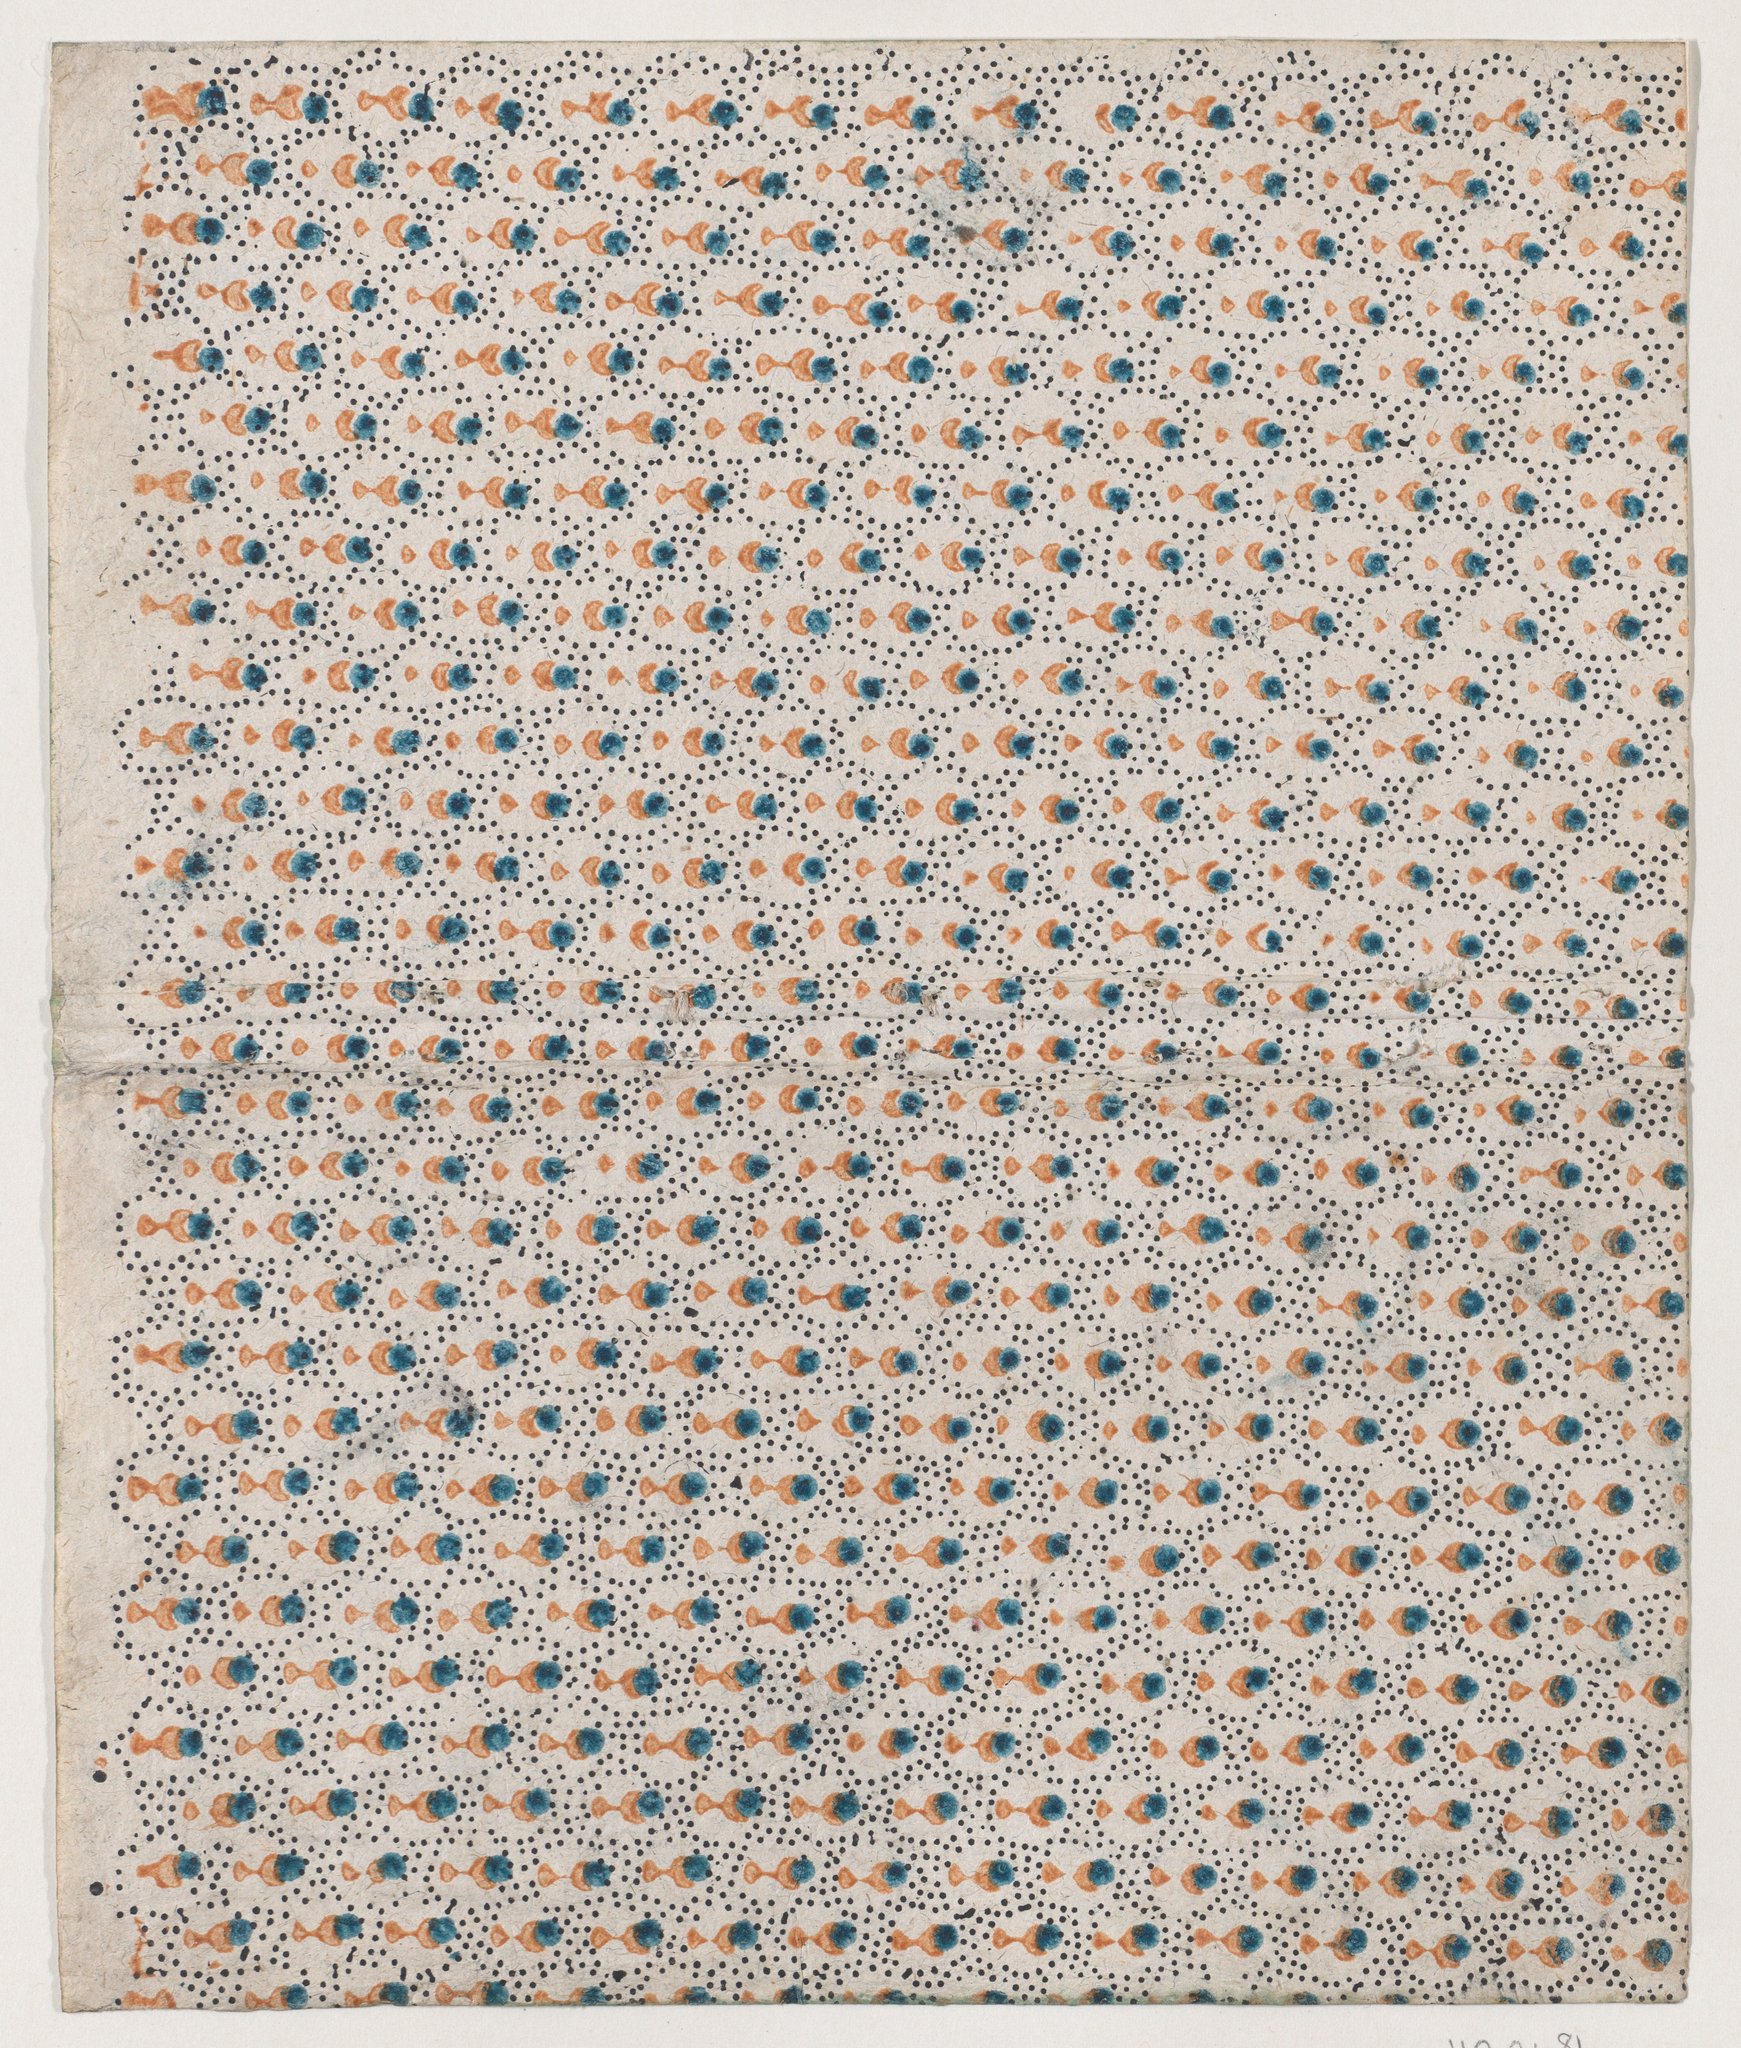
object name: print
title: Book cover with overall pattern of orange and blue dots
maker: Anonymous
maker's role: artist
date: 1801-1900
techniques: relief print